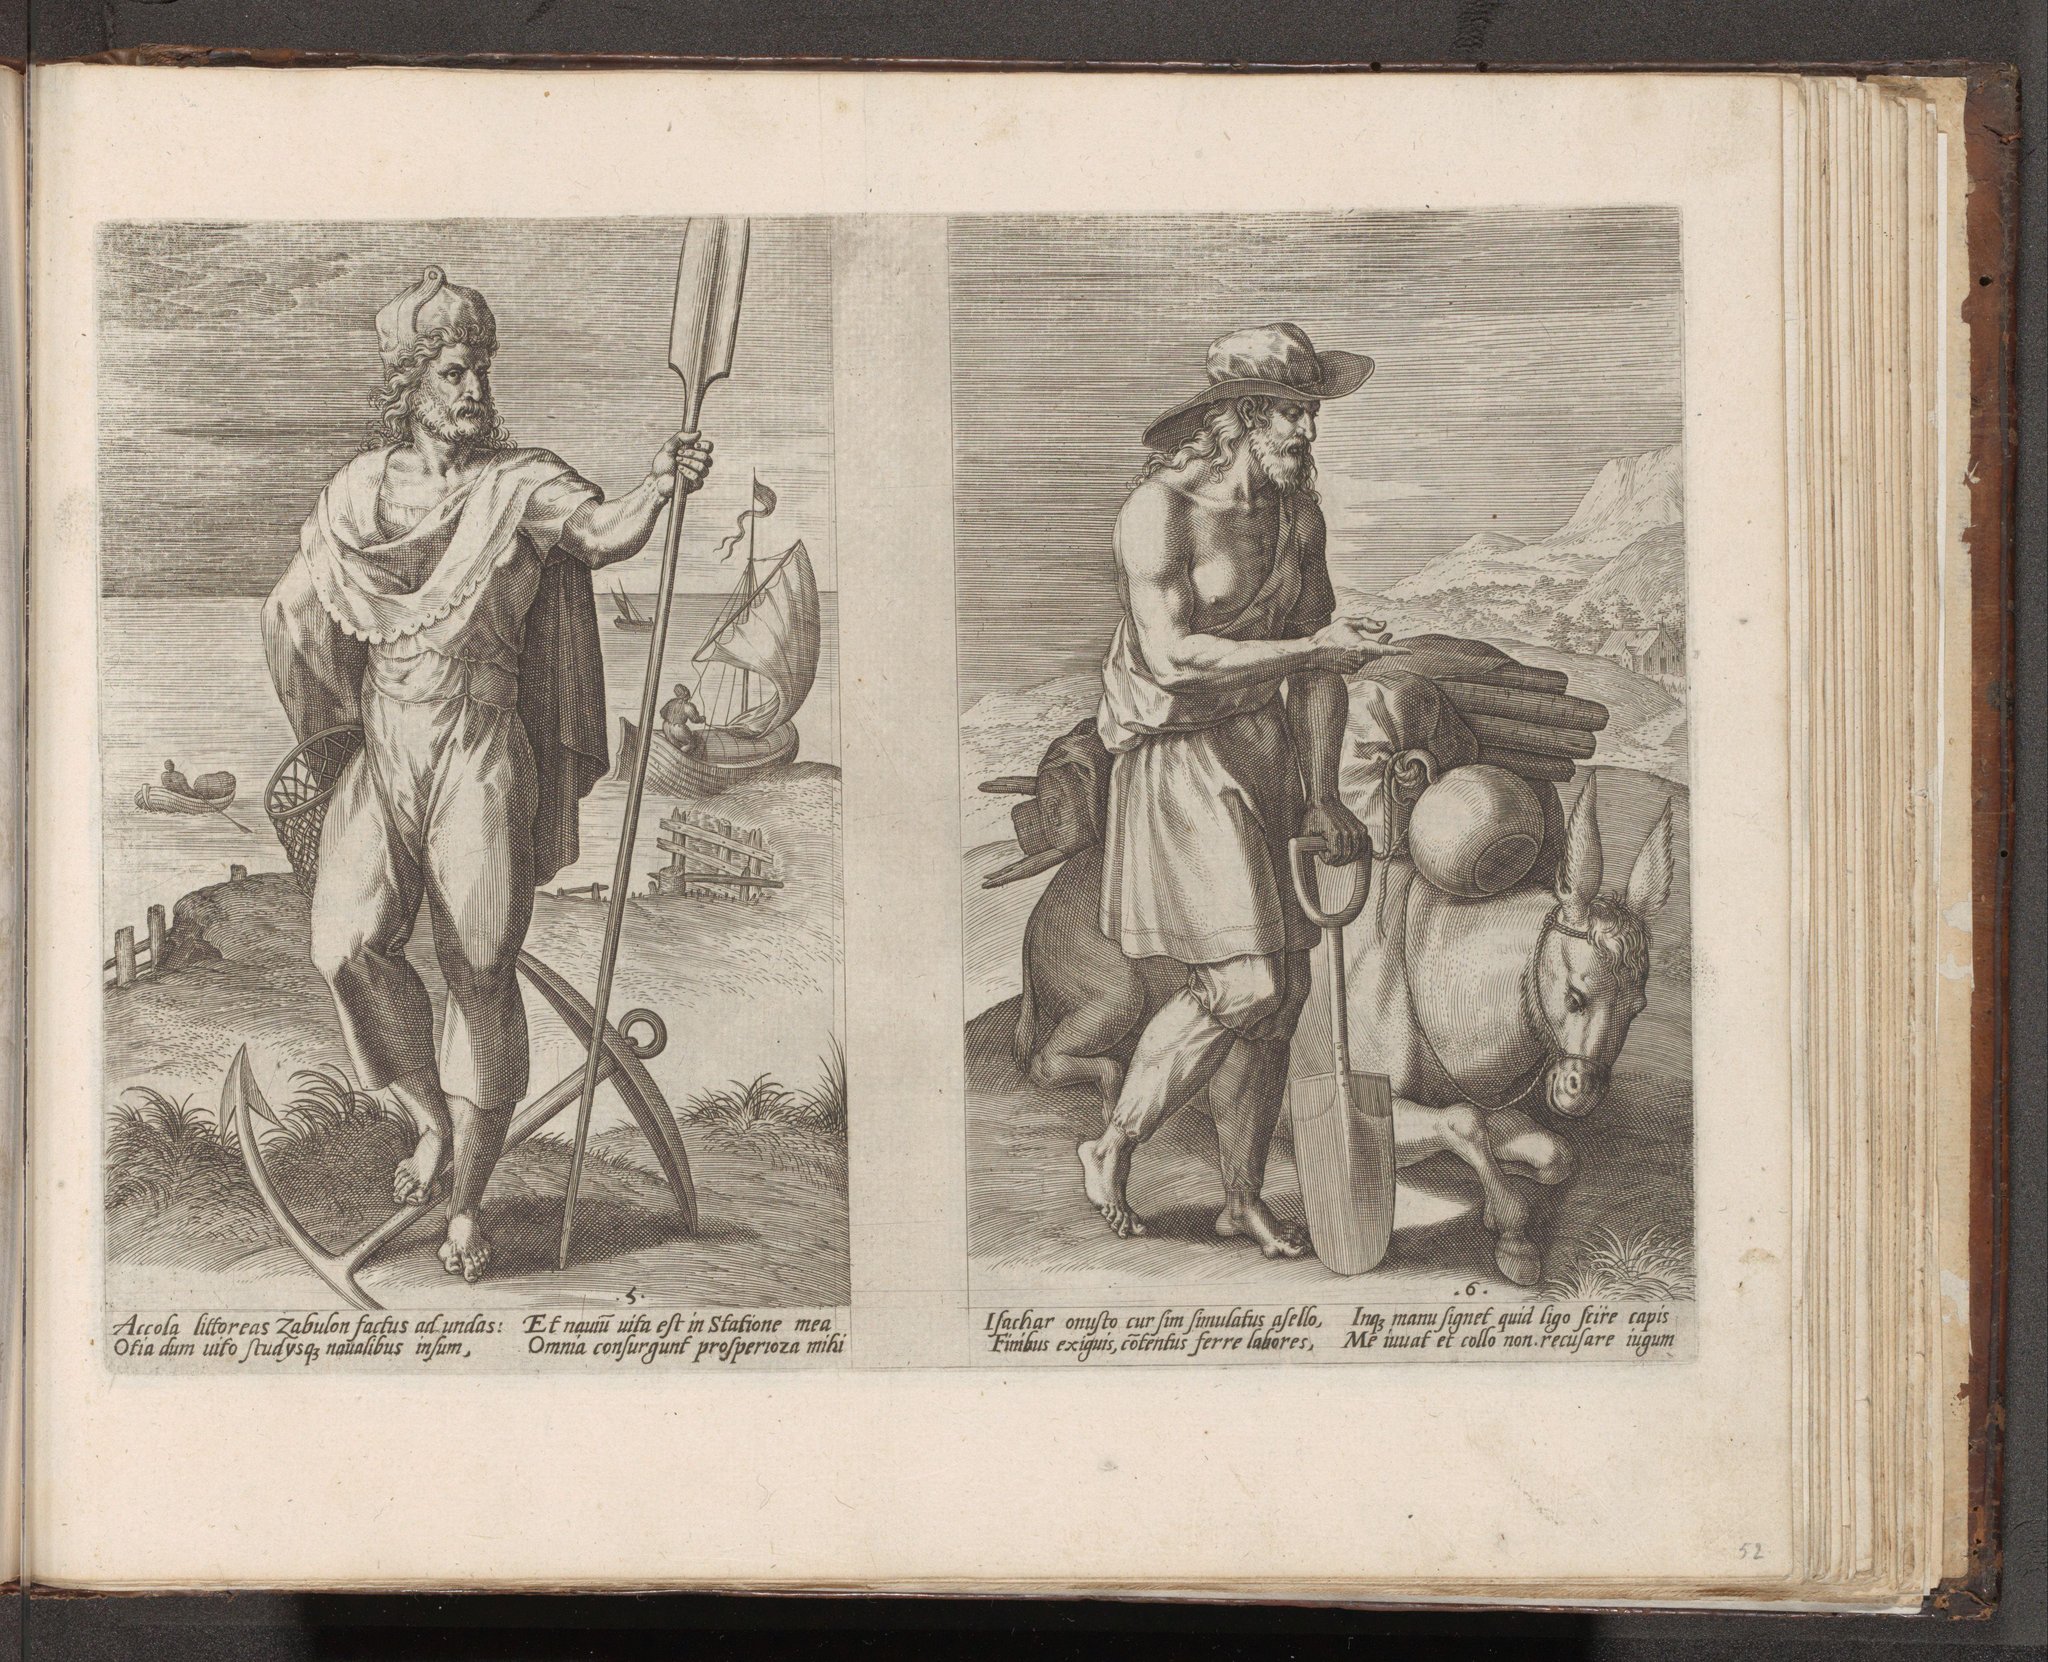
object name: album leaf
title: Historia duodecim patriarcharum (...)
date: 1579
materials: paper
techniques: engraving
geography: antwerp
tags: 11i611(issaschar), 11i611(zebulon)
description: Links stamvader Zebulon, de tiende zoon van Jakob. Hij is gekleed als visser. Op de grond naast hem een anker. Op de achtergrond de zee en een strand, een verwijzing naar de woonplaats van Zebulon. Rechts stamvader Issachar, de negende zoon van Jakob. Naast hem ligt een ezel, een verwijzingen naar Issachar als een 'sterke ezel'. Onder de voorstellingen een verwijzing in het Latijn naar de Bijbeltekst. Prent maakt deel uit van een album.